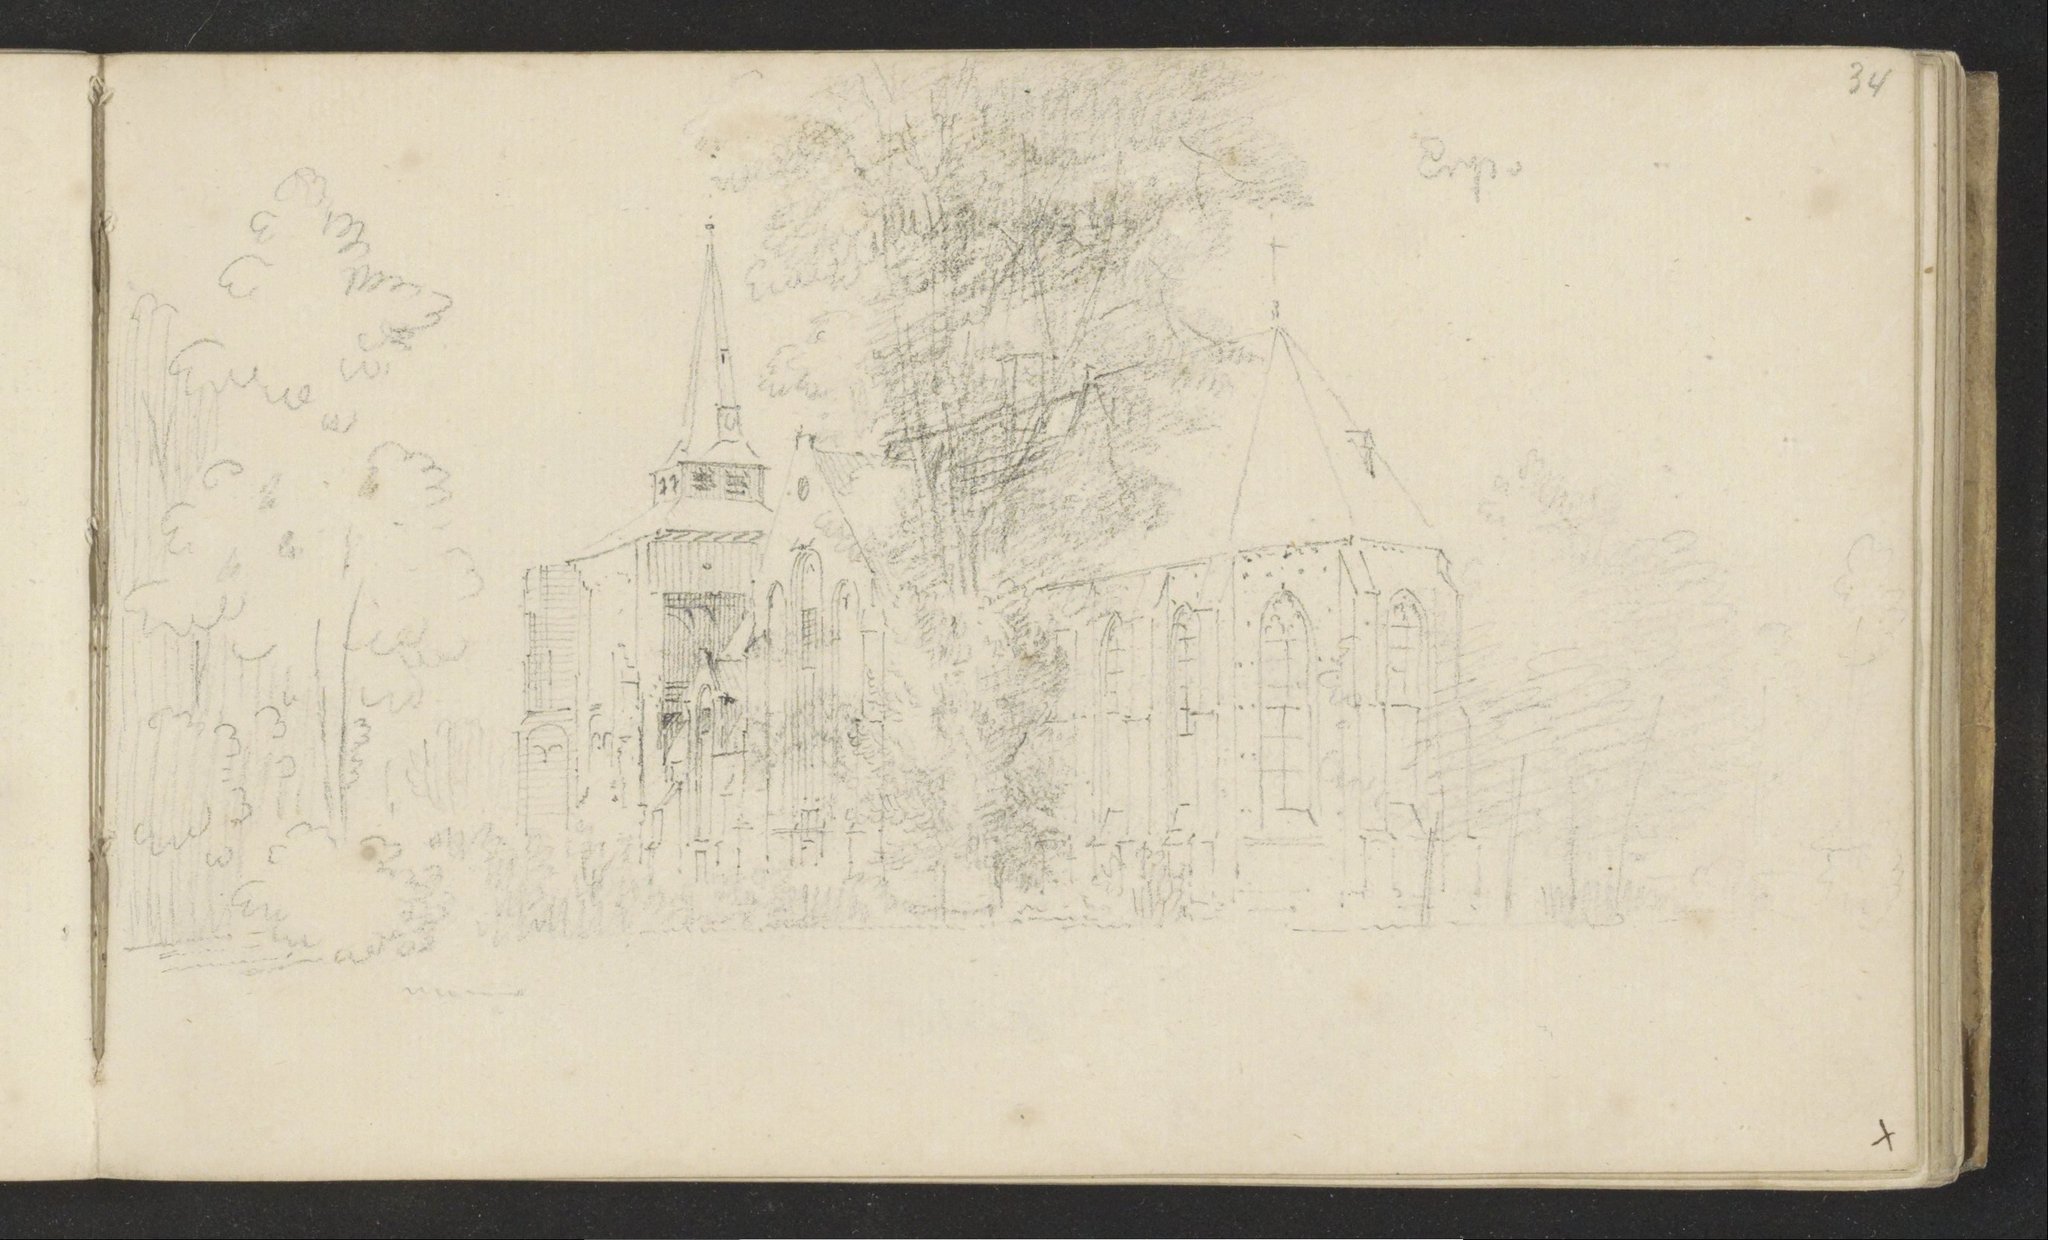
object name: sketchbook leaf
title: Kerk te Erp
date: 1701-1759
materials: paper, pencil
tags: church (exterior)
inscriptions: annotation: ‘Erp’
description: Blad 34 recto uit een schetsboek met 65 bladen.